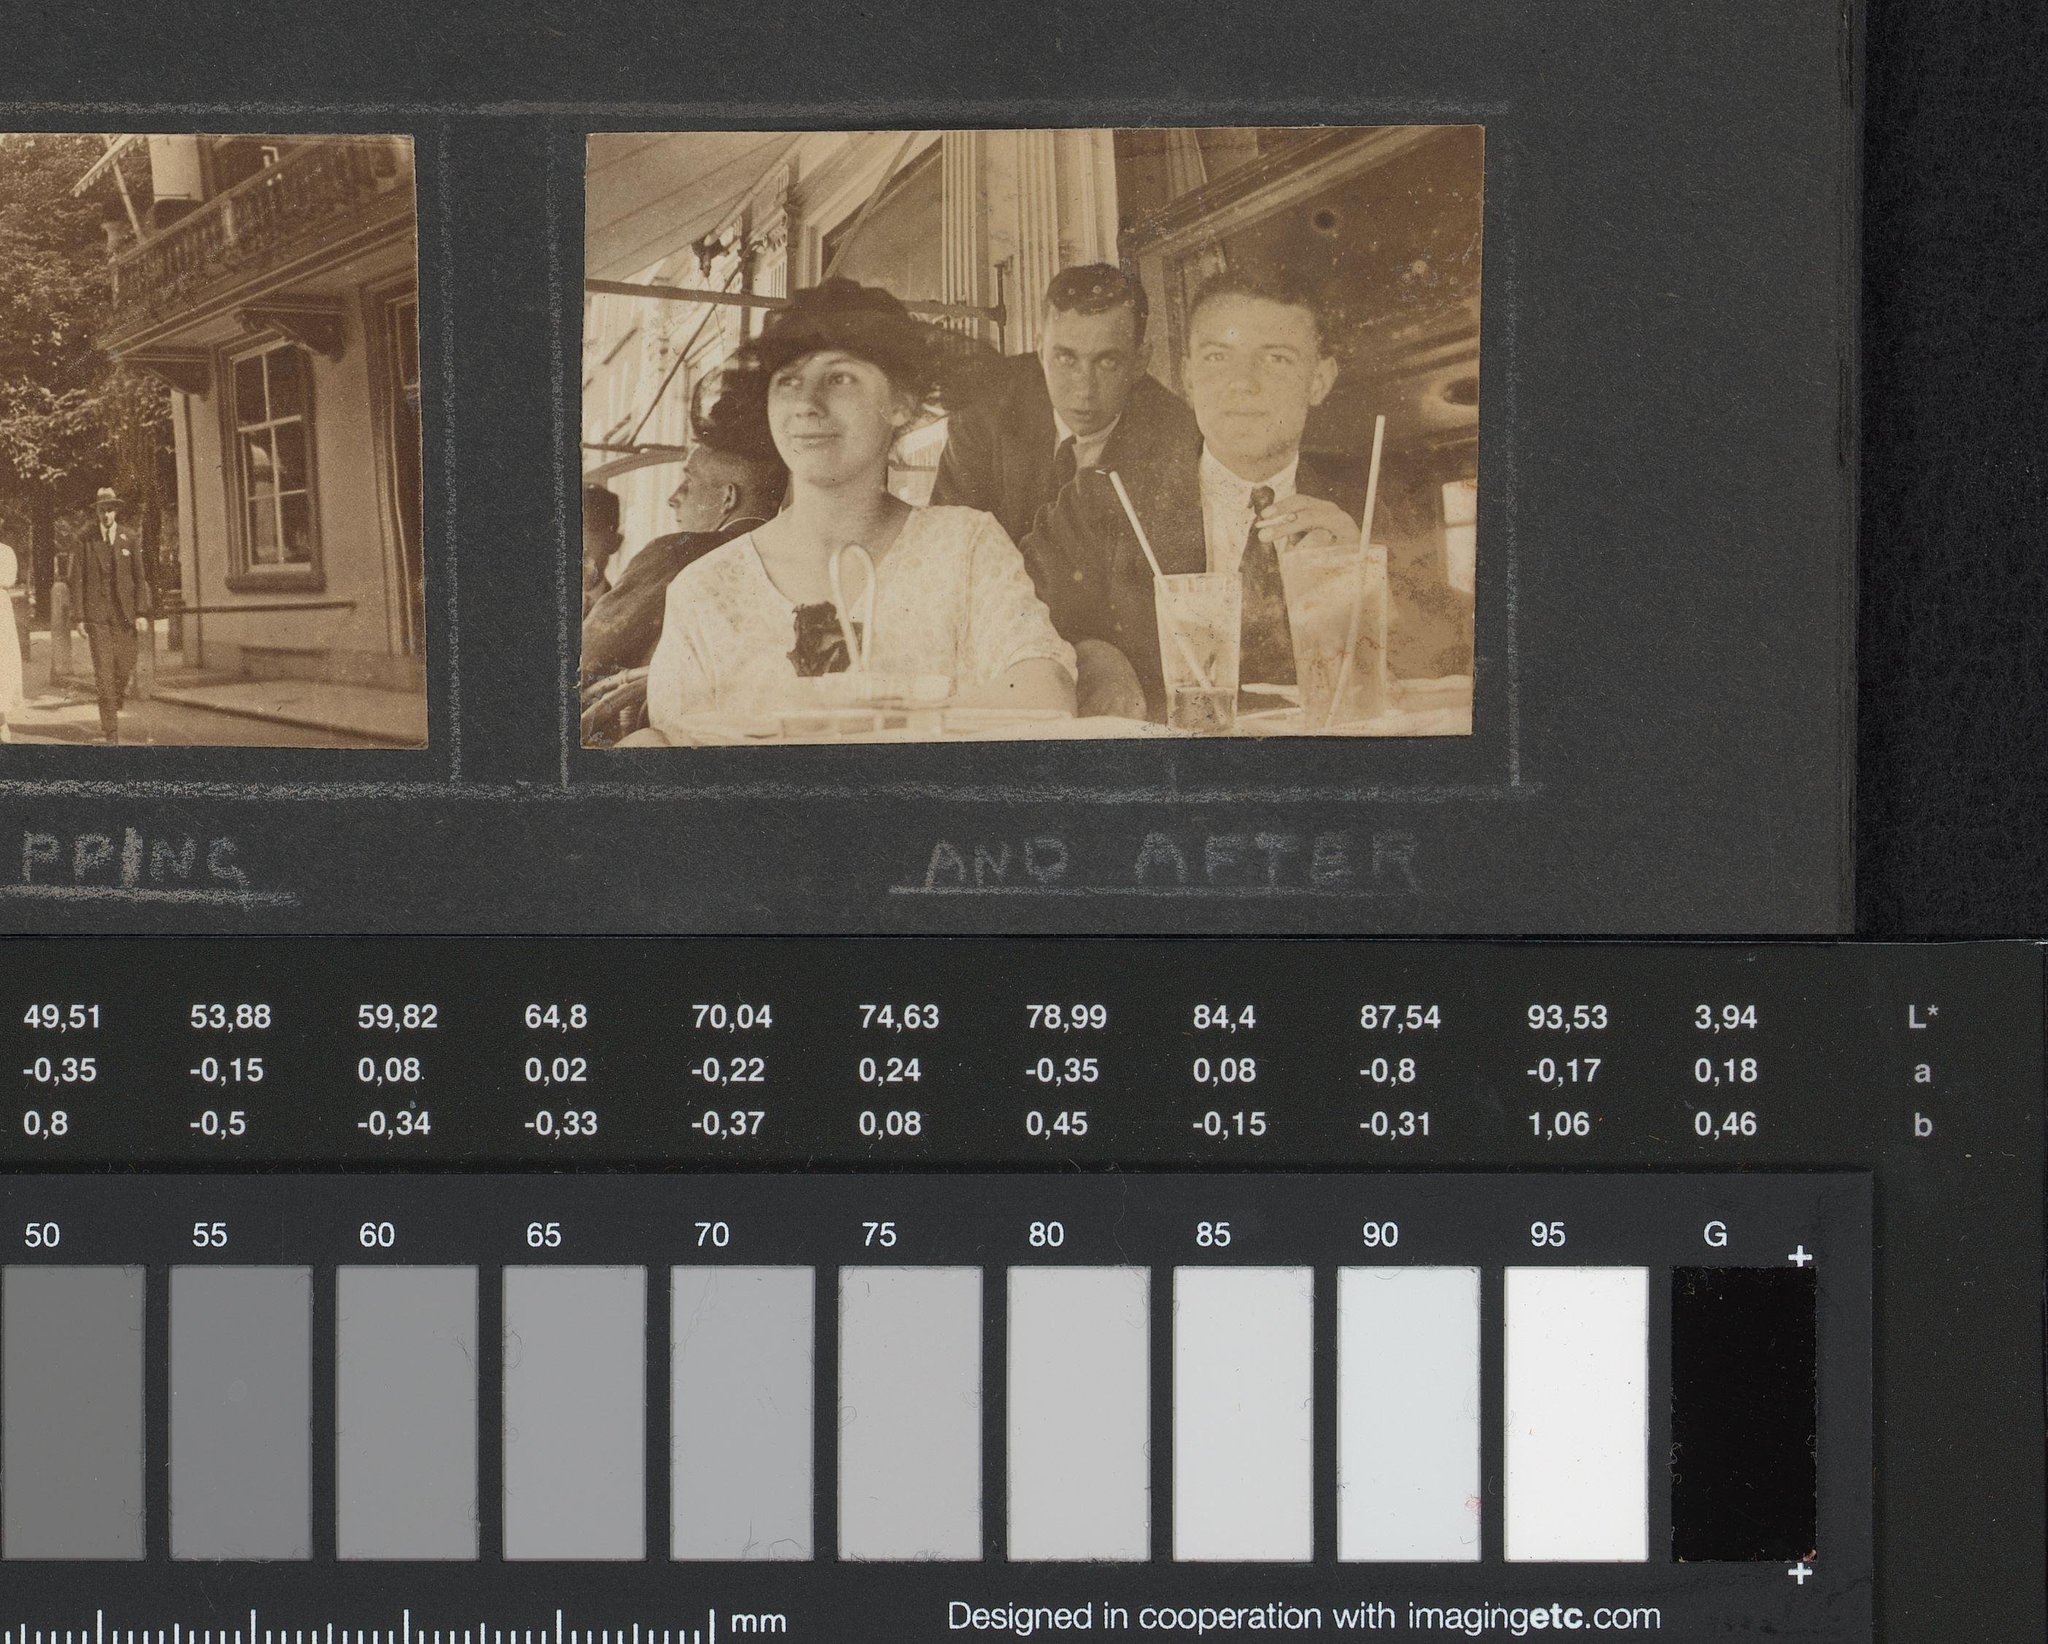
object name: photograph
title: and after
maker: Anonymous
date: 1920-1925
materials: paper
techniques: gelatin silver print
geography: south holland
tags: adult woman, adult man, drinks, stimulants, drugs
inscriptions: inscription: ‘We buy dresses for the girl’